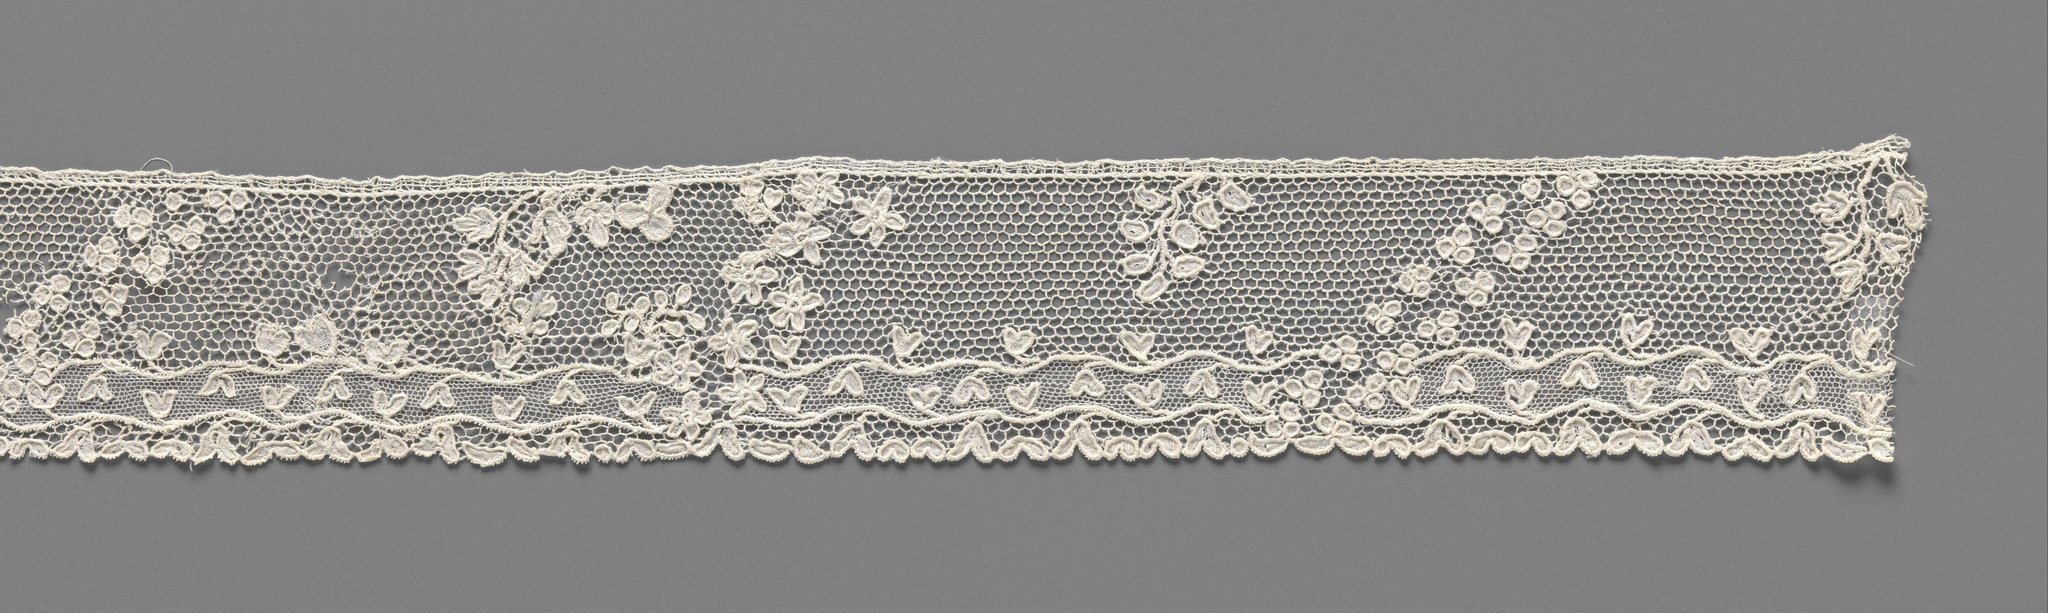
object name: strip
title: Strook naaldkant met hartvormige blaadjes in sierband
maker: Anonymous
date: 1790-1799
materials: linen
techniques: lace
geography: argentan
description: Strook naturelkleurig naaldkant: Argentan-kant. Het zich herhalende patroon bestaat uit een schuin van onder naar boven toe lopende baan, gevormd door een dubbel rij bloempjes, elk bloempje met drie ronde bloemblaadjes. Tussen de twee op elkaar volgende schuine banen hangen bloem- en bladtakjes naar beneden. Parallel langs de onderrand loopt een doorgaande sierband met hartvormige blaadjes erin. Direct onder de sierband vormen hartvormige en min of meer ovaalvormige motiefjes de schulpjes langs de rechte onderzijde van de strook. De motiefjes zijn opgebouwd uit festonsteken met spaarzaam toegepaste uitsparingen. Rond alle motiefjes lopen reliëfcontouren al dan niet voorzien van picots. De motieven zijn met elkaar verbonden door een grond van zeshoekige mazen, die dicht omnaaid zijn met festonsteken, een Argentan-grond. In de sierband met de hartvormige blaadjes is een fijnere maasgrond toegepast. De bovenzijde is afgewerkt met een geklost bandje.